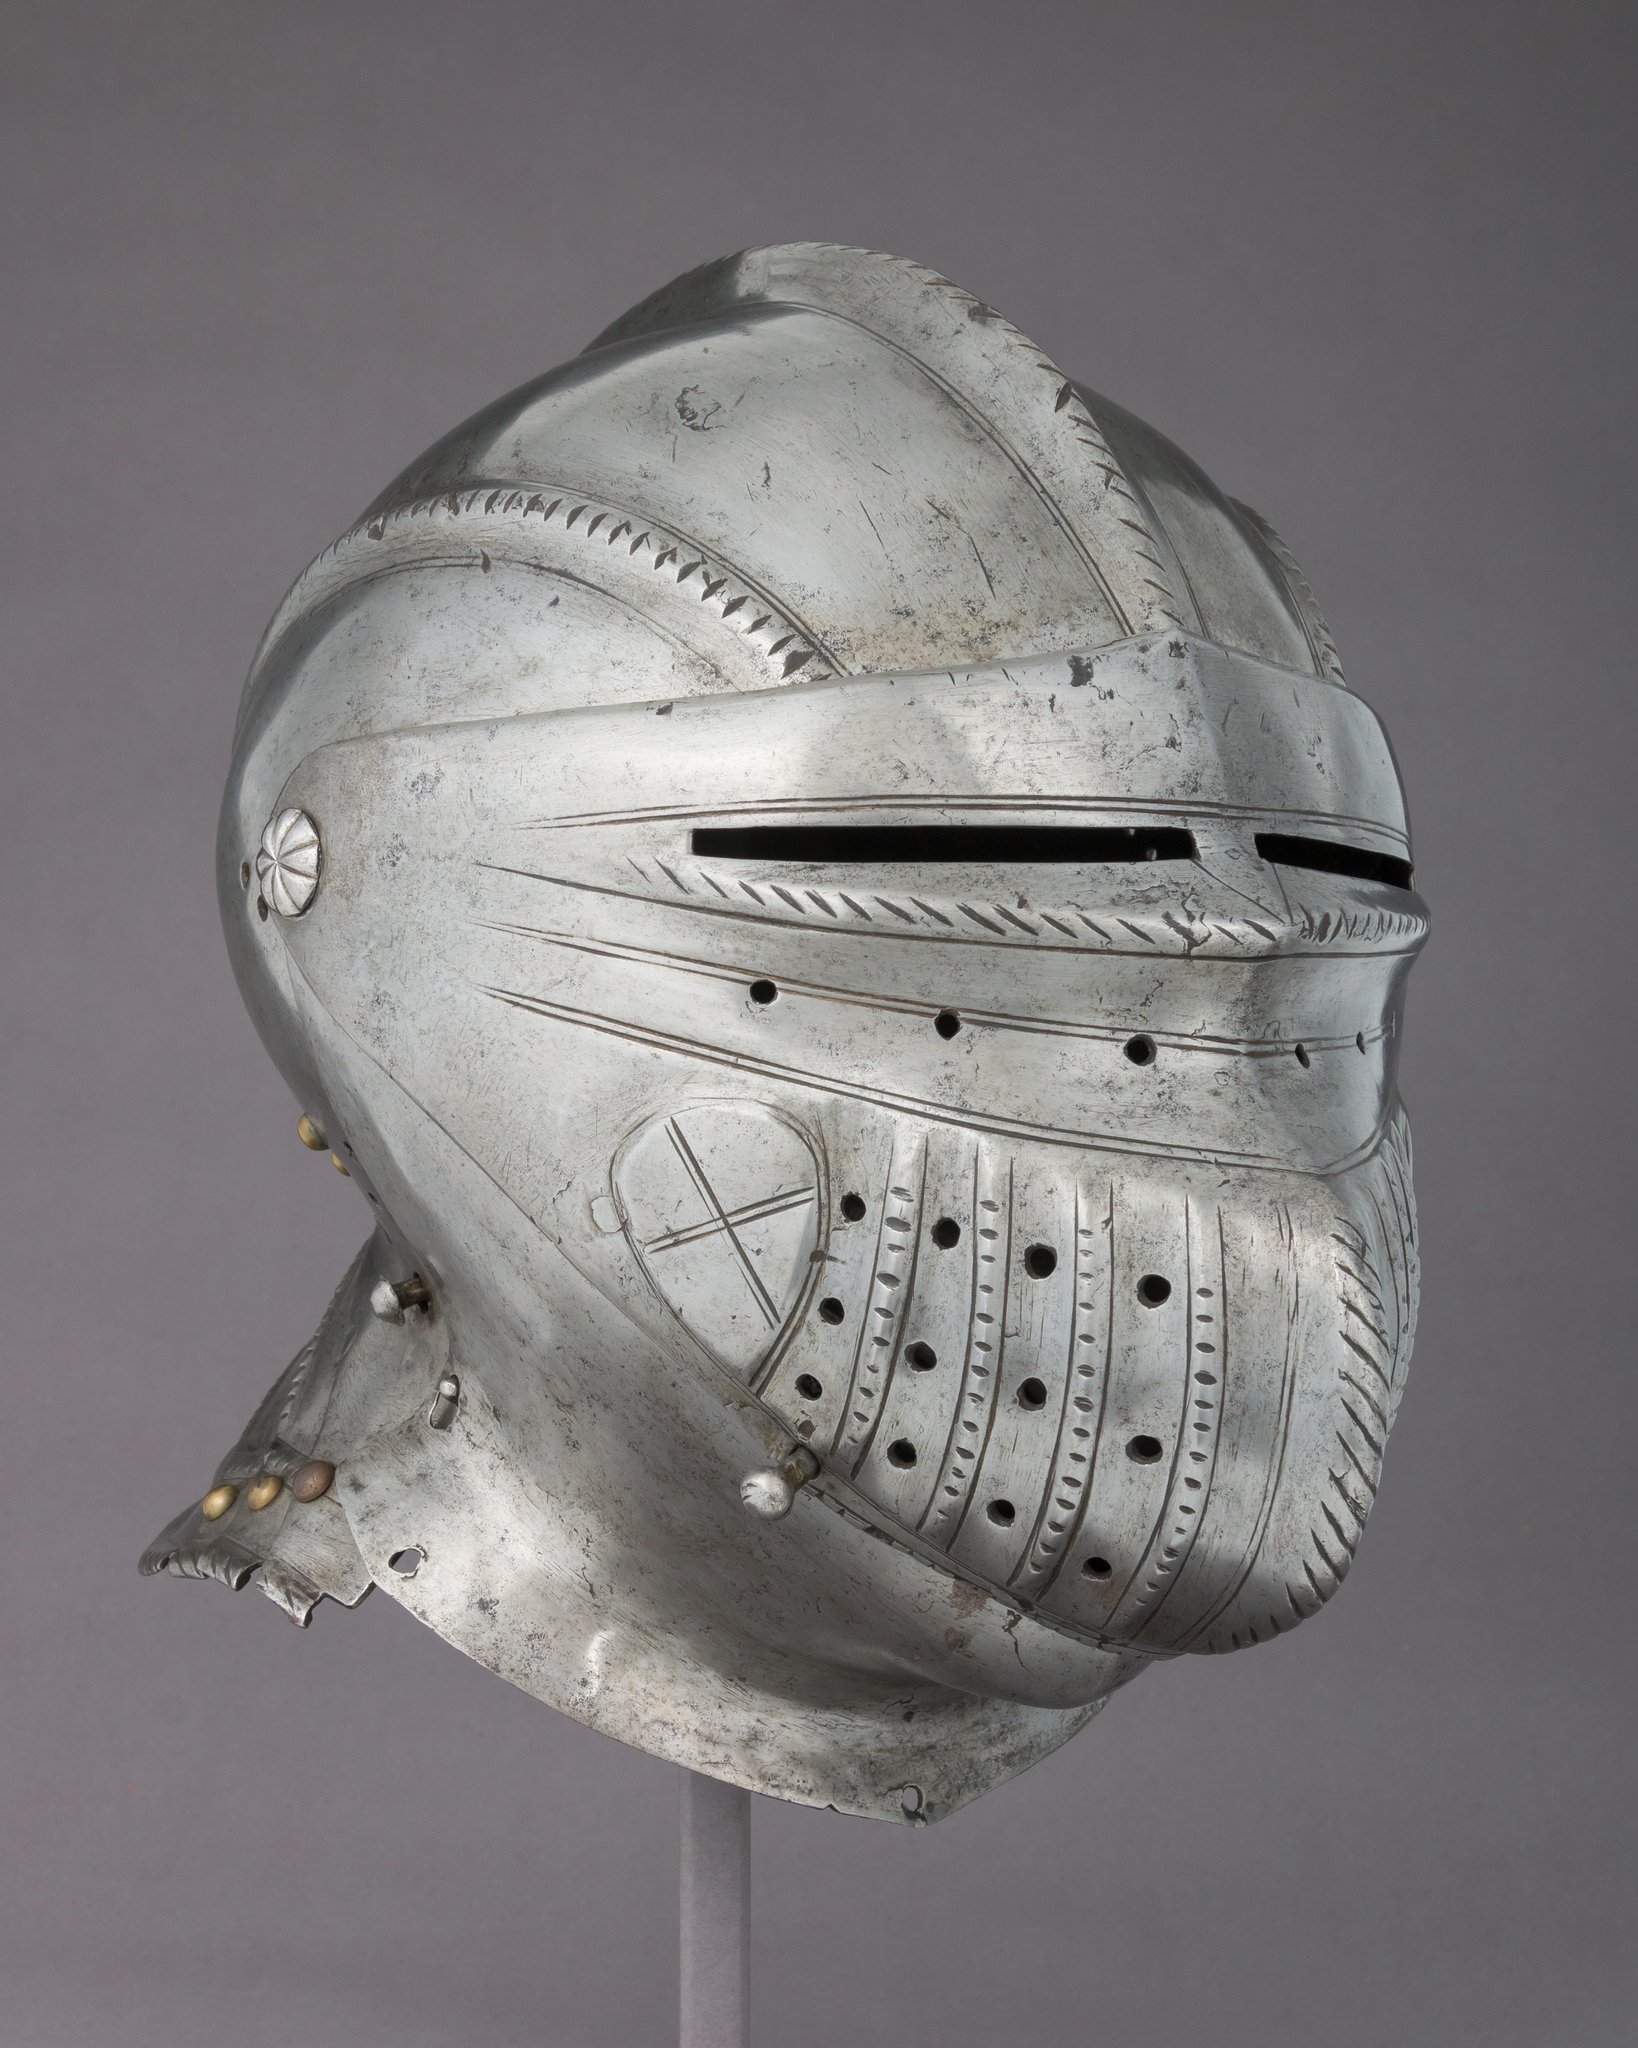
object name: close helmet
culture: german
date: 1535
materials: brass, steel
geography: germany